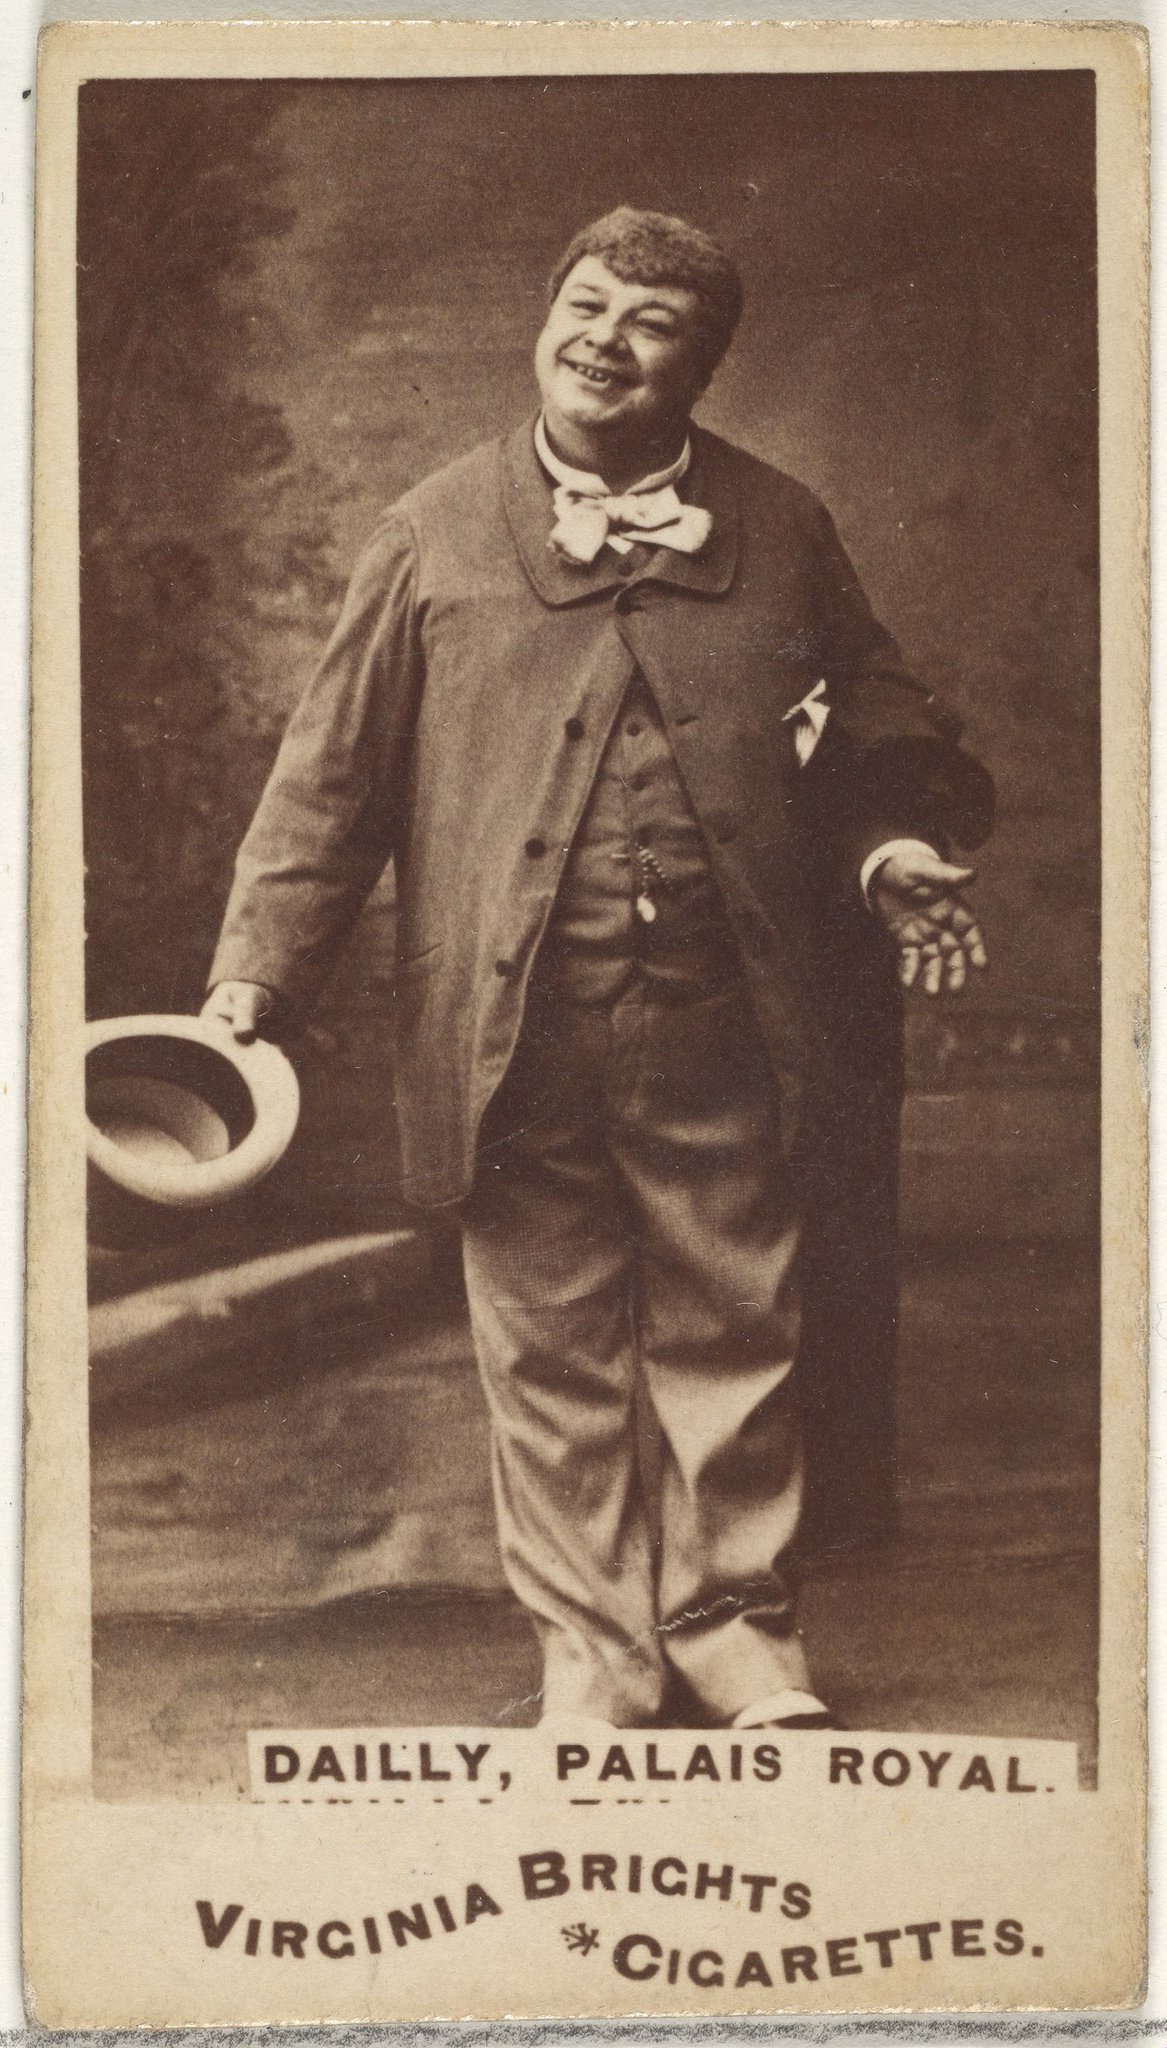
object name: photograph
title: Dailly, Palais Royal, from the Actors and Actresses series (N45, Type 1) for Virginia Brights Cigarettes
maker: allen & ginter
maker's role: publisher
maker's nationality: american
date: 1888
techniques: albumen silver print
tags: happiness,men,portraits,actors